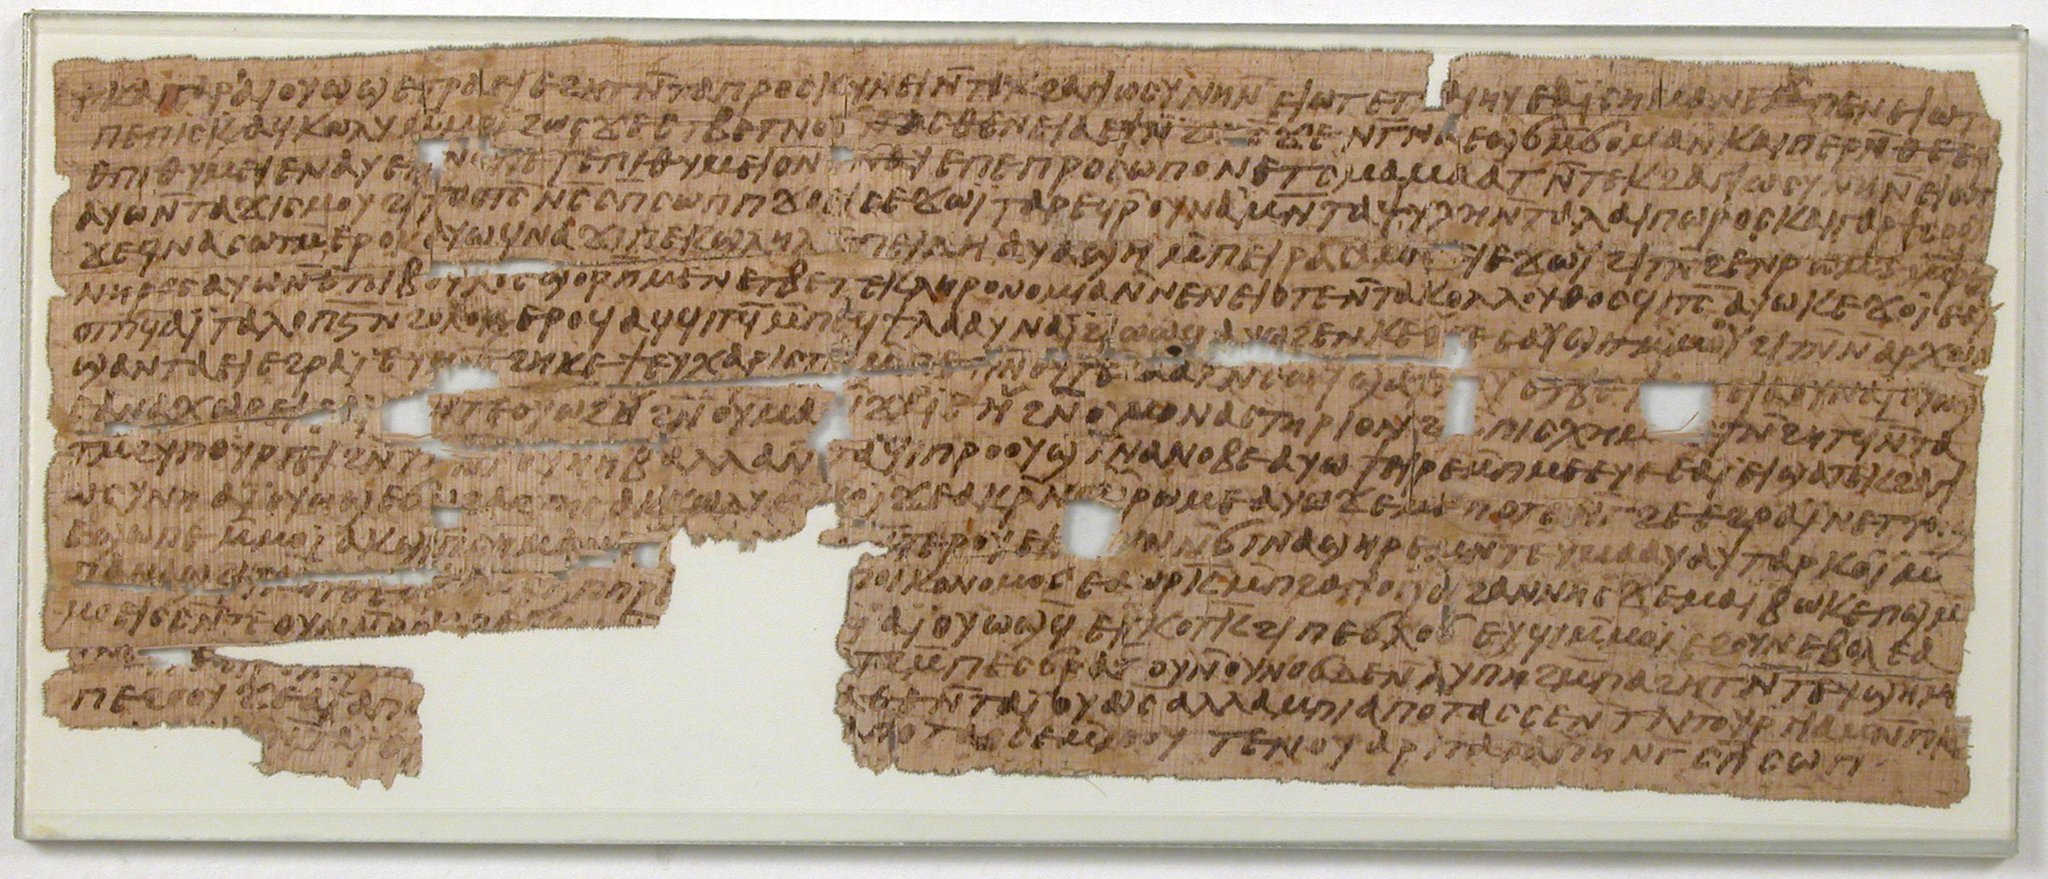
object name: papyrus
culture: coptic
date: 601-700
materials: ink, papyrus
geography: egypt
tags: coptic,documents